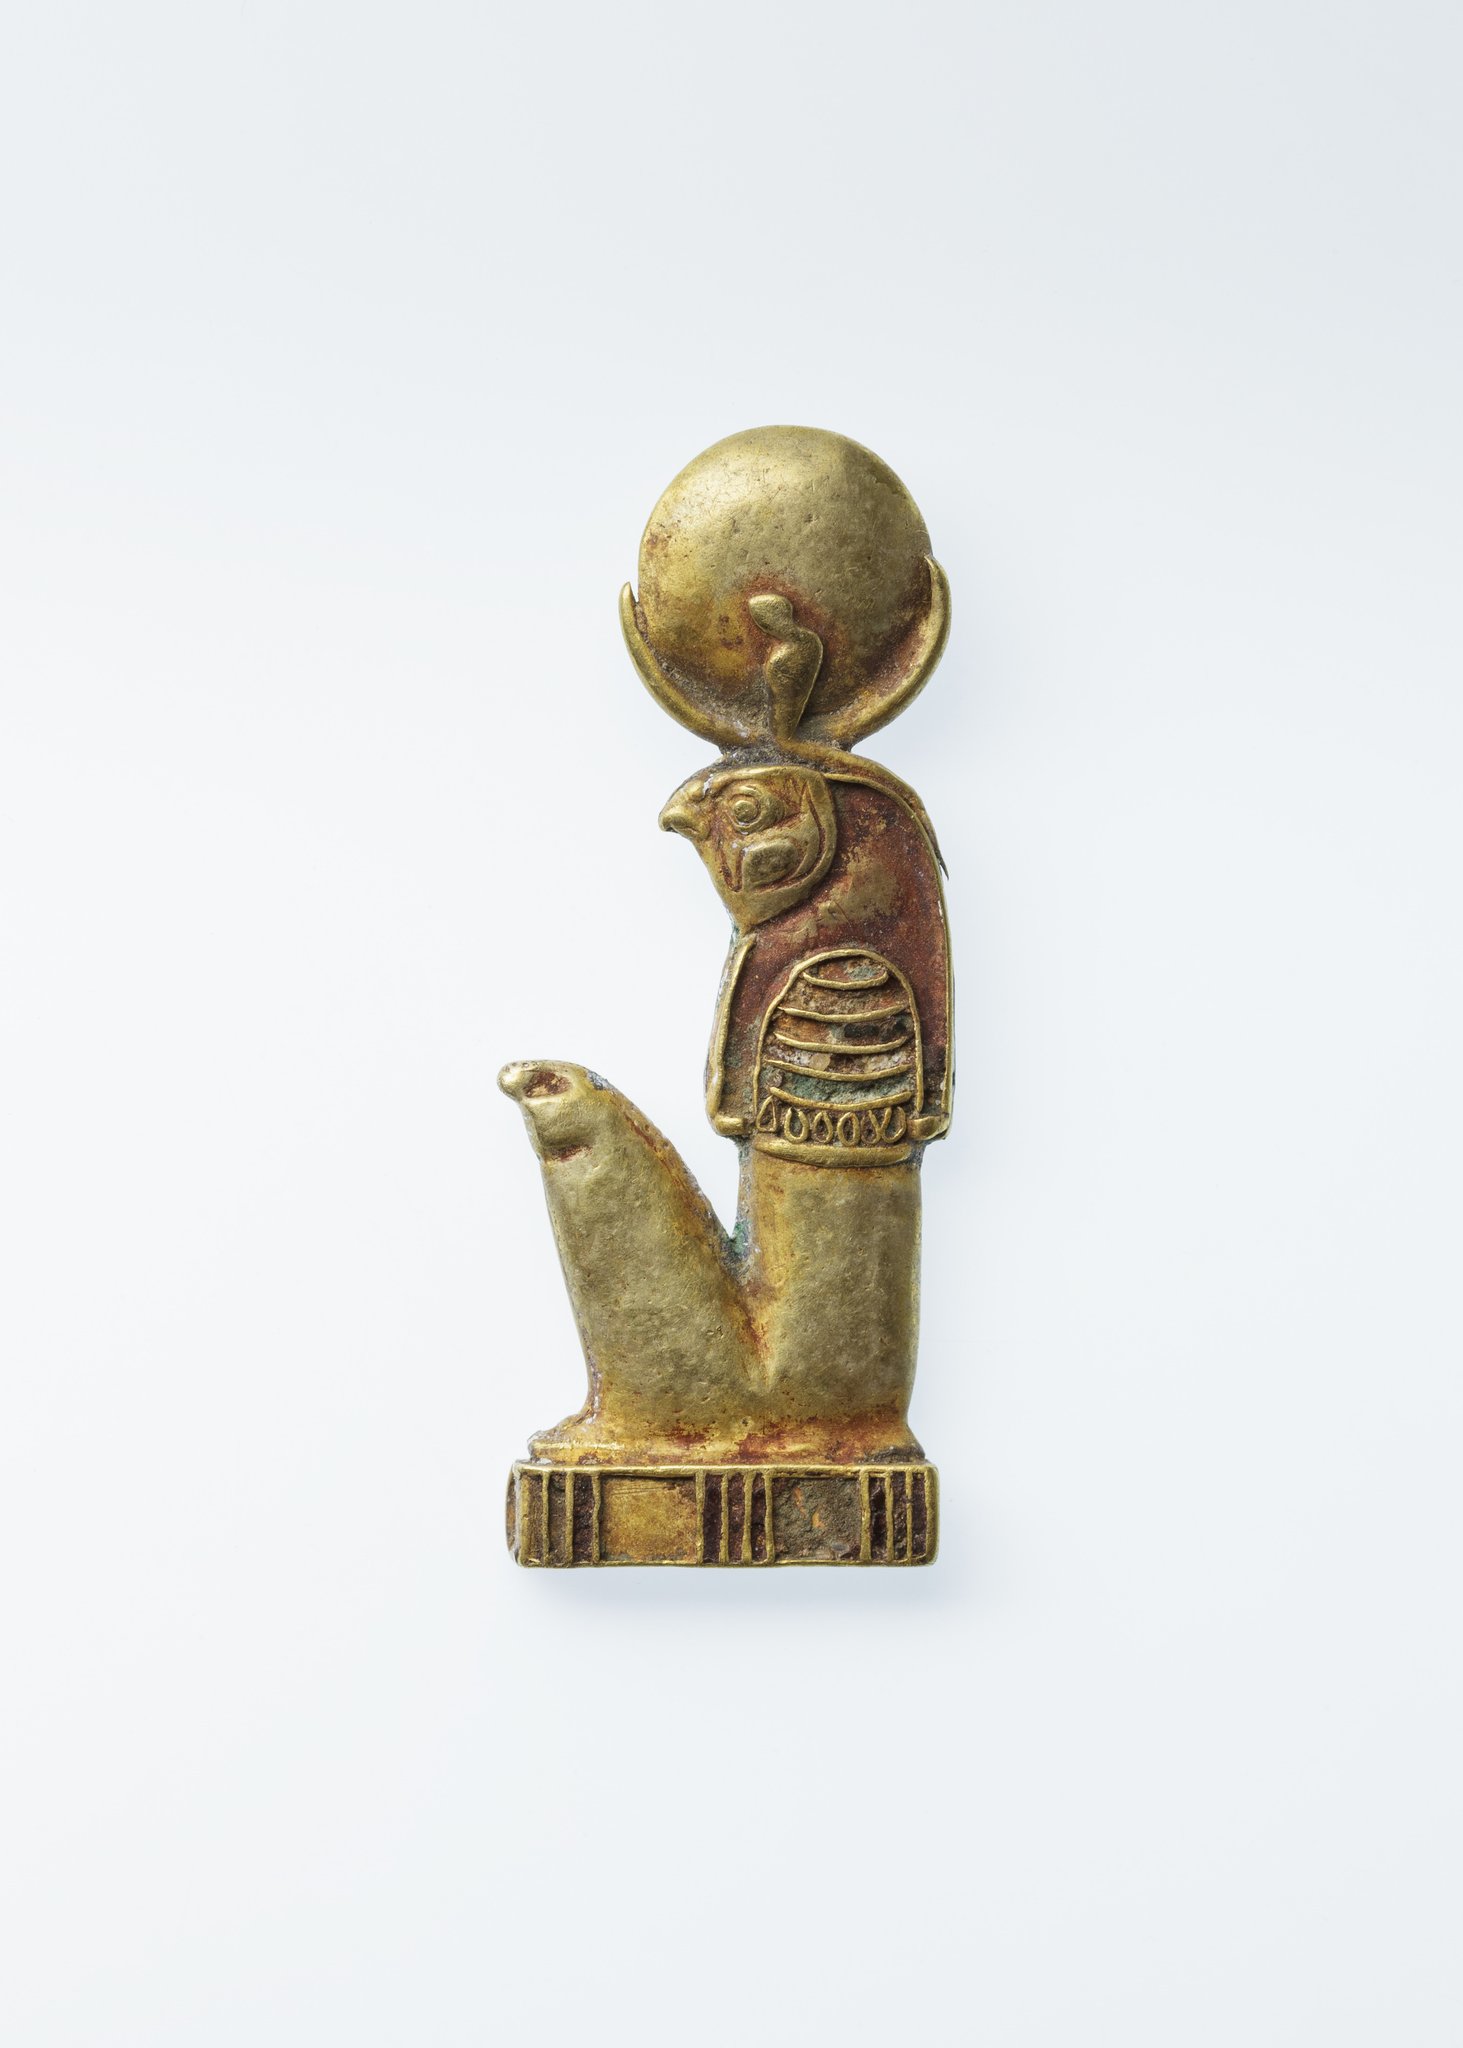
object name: pendant, khonsu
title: Khonsu pendant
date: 1295-1070 BCE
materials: gold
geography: egypt